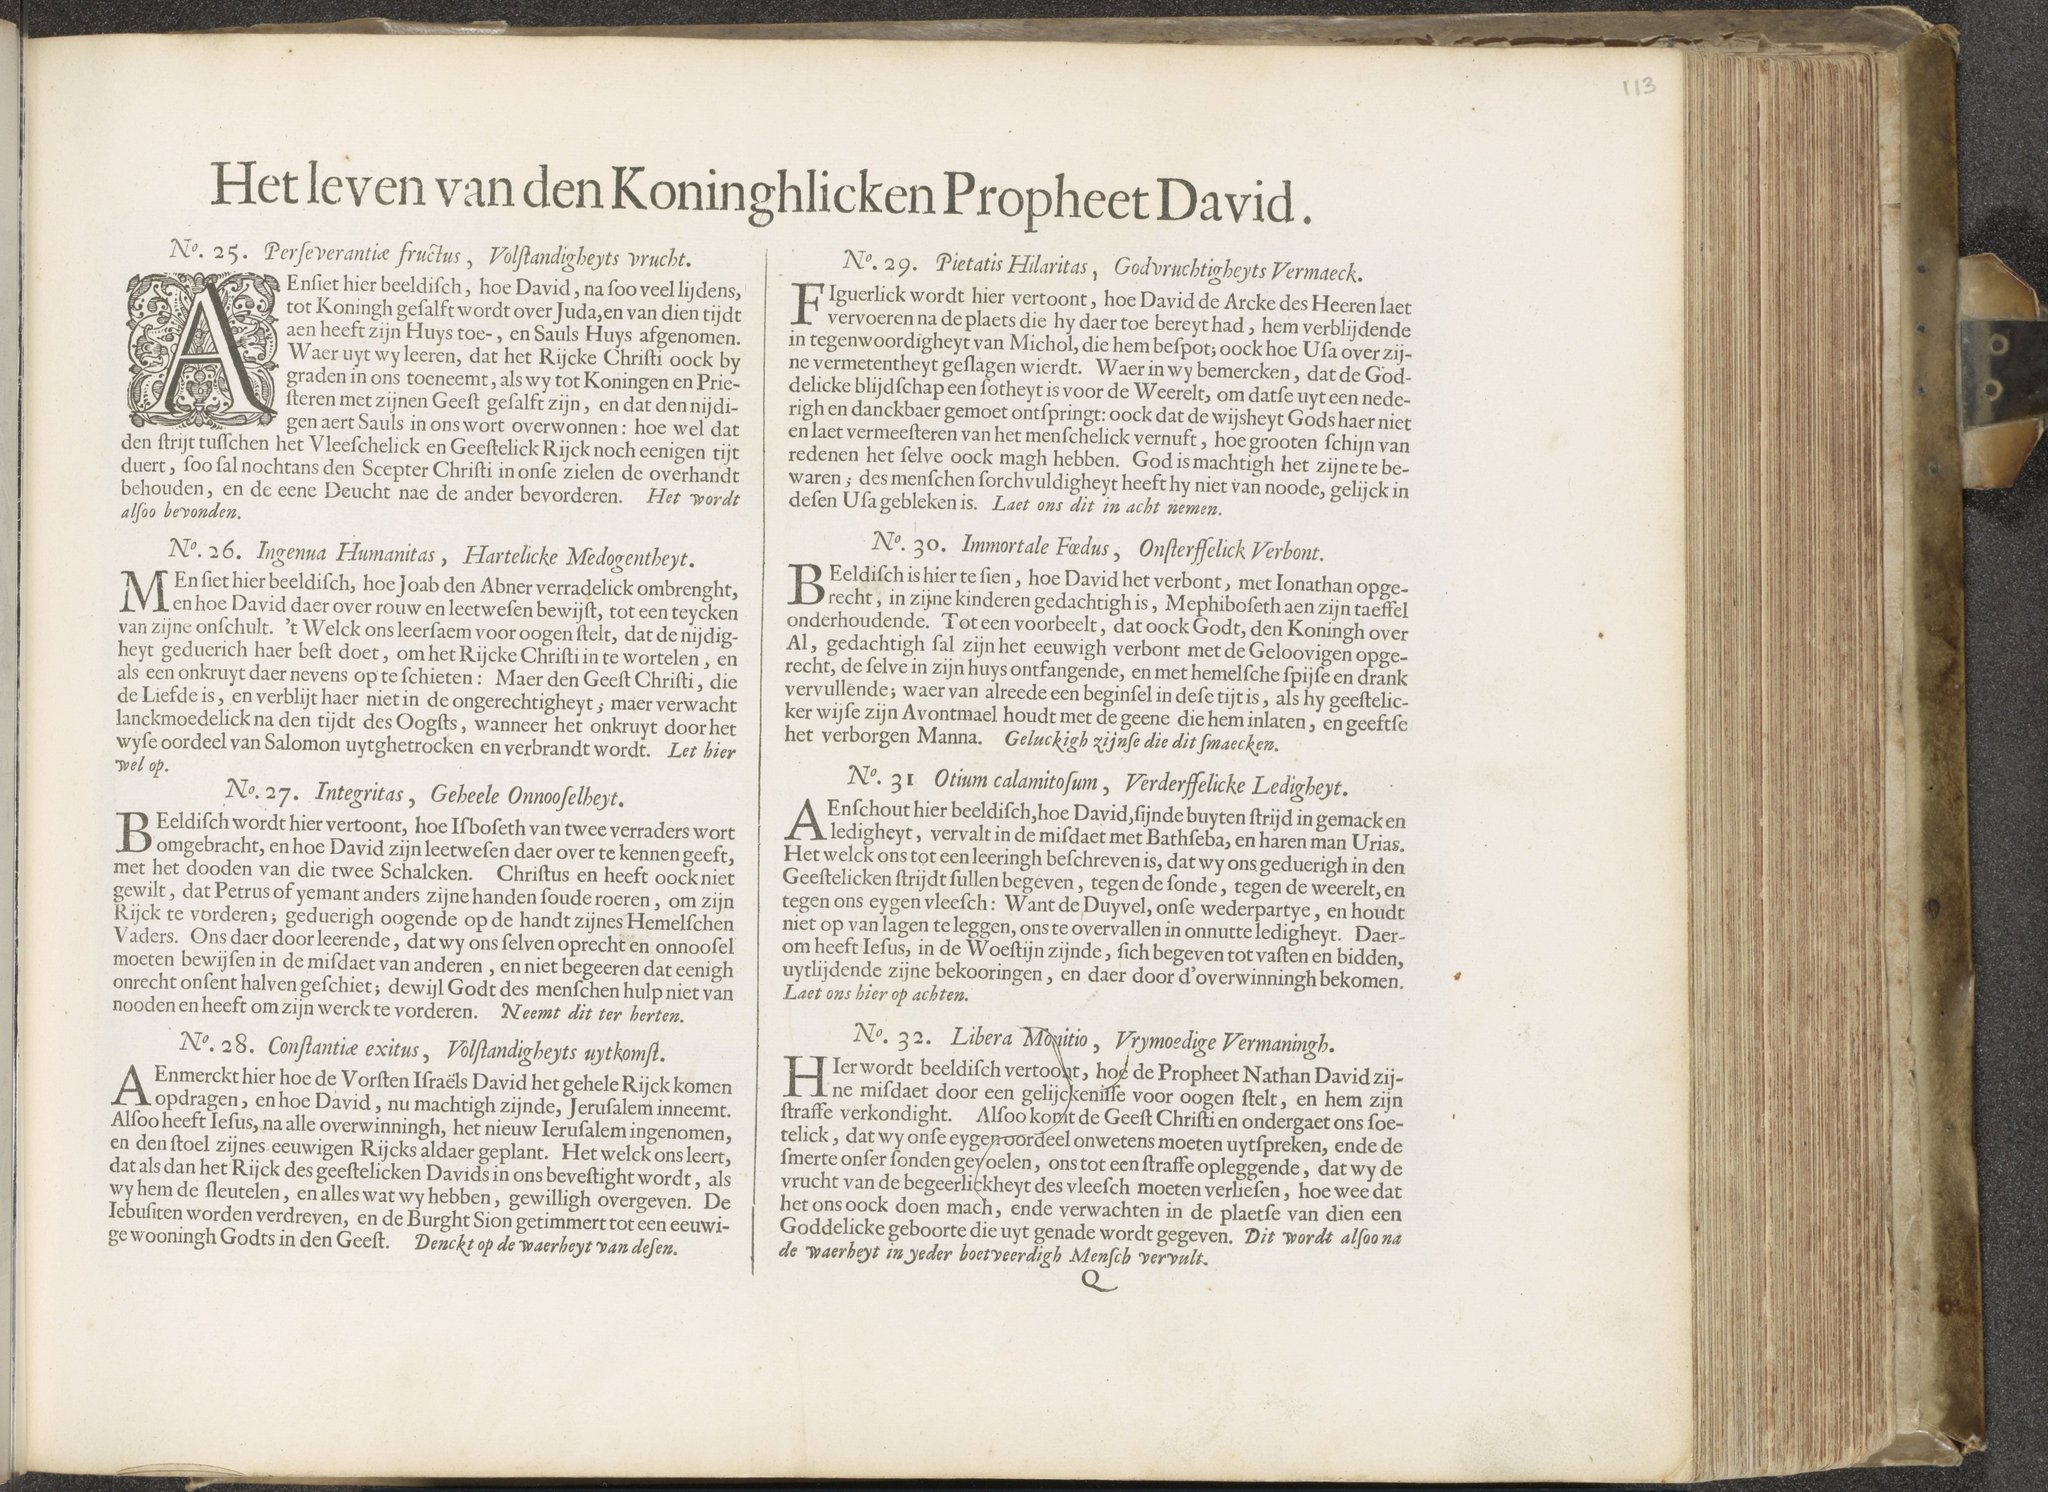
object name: text sheet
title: Acht toelichtingen bij voorstellingen over het leven van David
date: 1653-1654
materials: paper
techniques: letterpress printing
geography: amsterdam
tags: initial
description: Acht toelichtingen bij voorstellingen over het leven van David, genummerd 25 tot en met 32. De tekst vangt aan met een gedecoreerde initiaal A. Het blad maakt deel uit van een album.